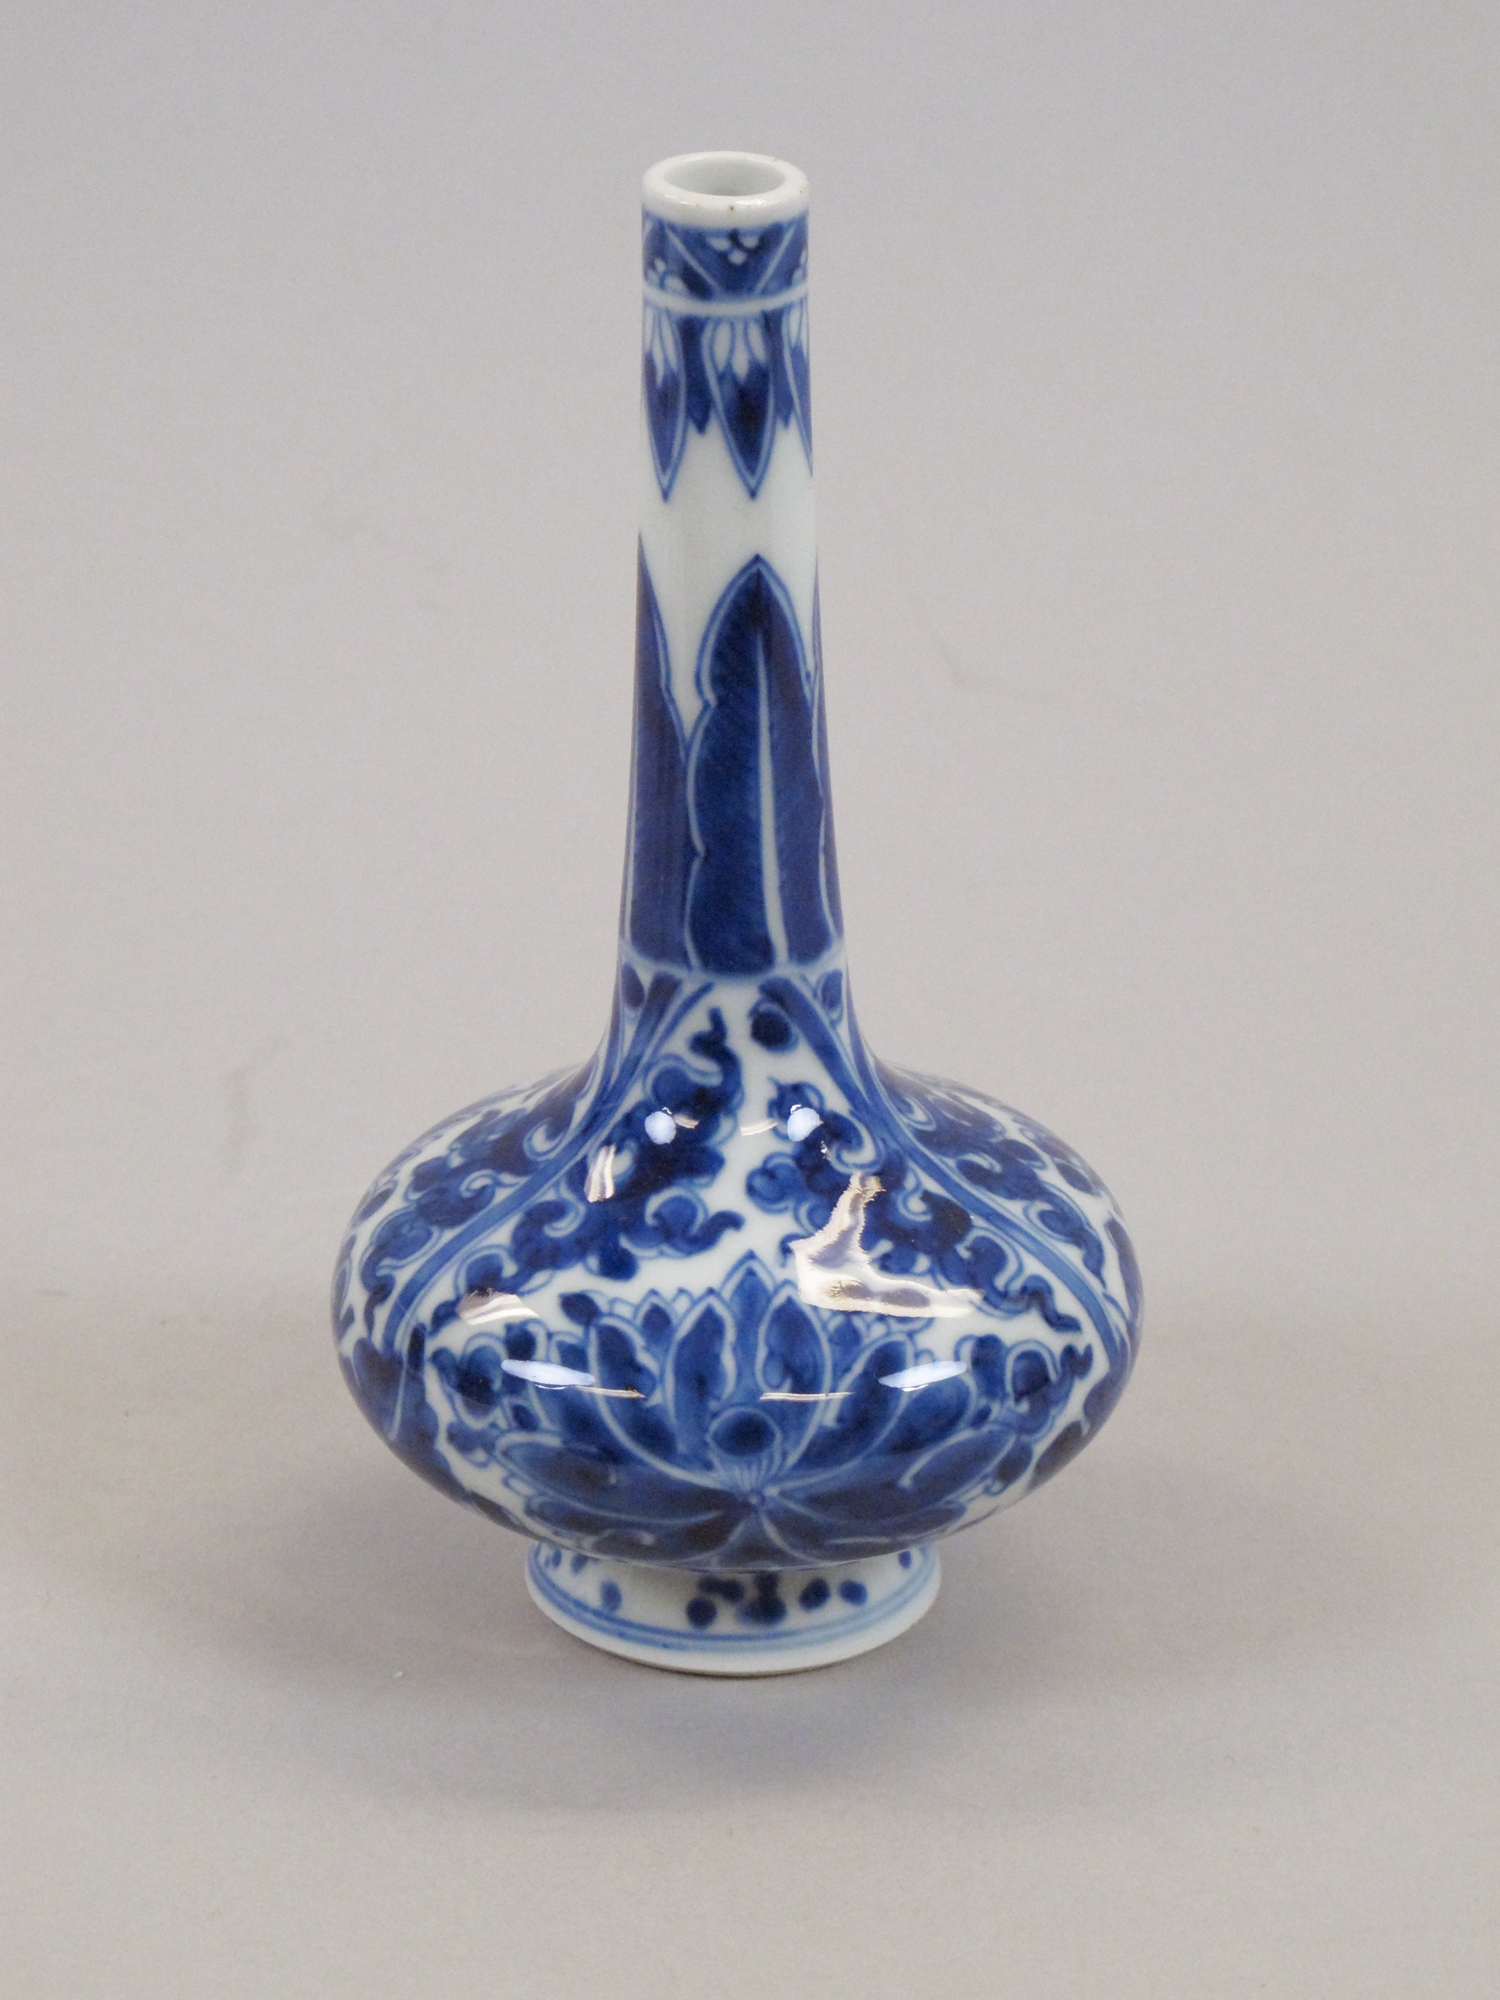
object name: bottle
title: Bottle with floral scrolls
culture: chinese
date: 1667-1733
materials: cobalt, porcelain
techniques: painting, underglaze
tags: flowers